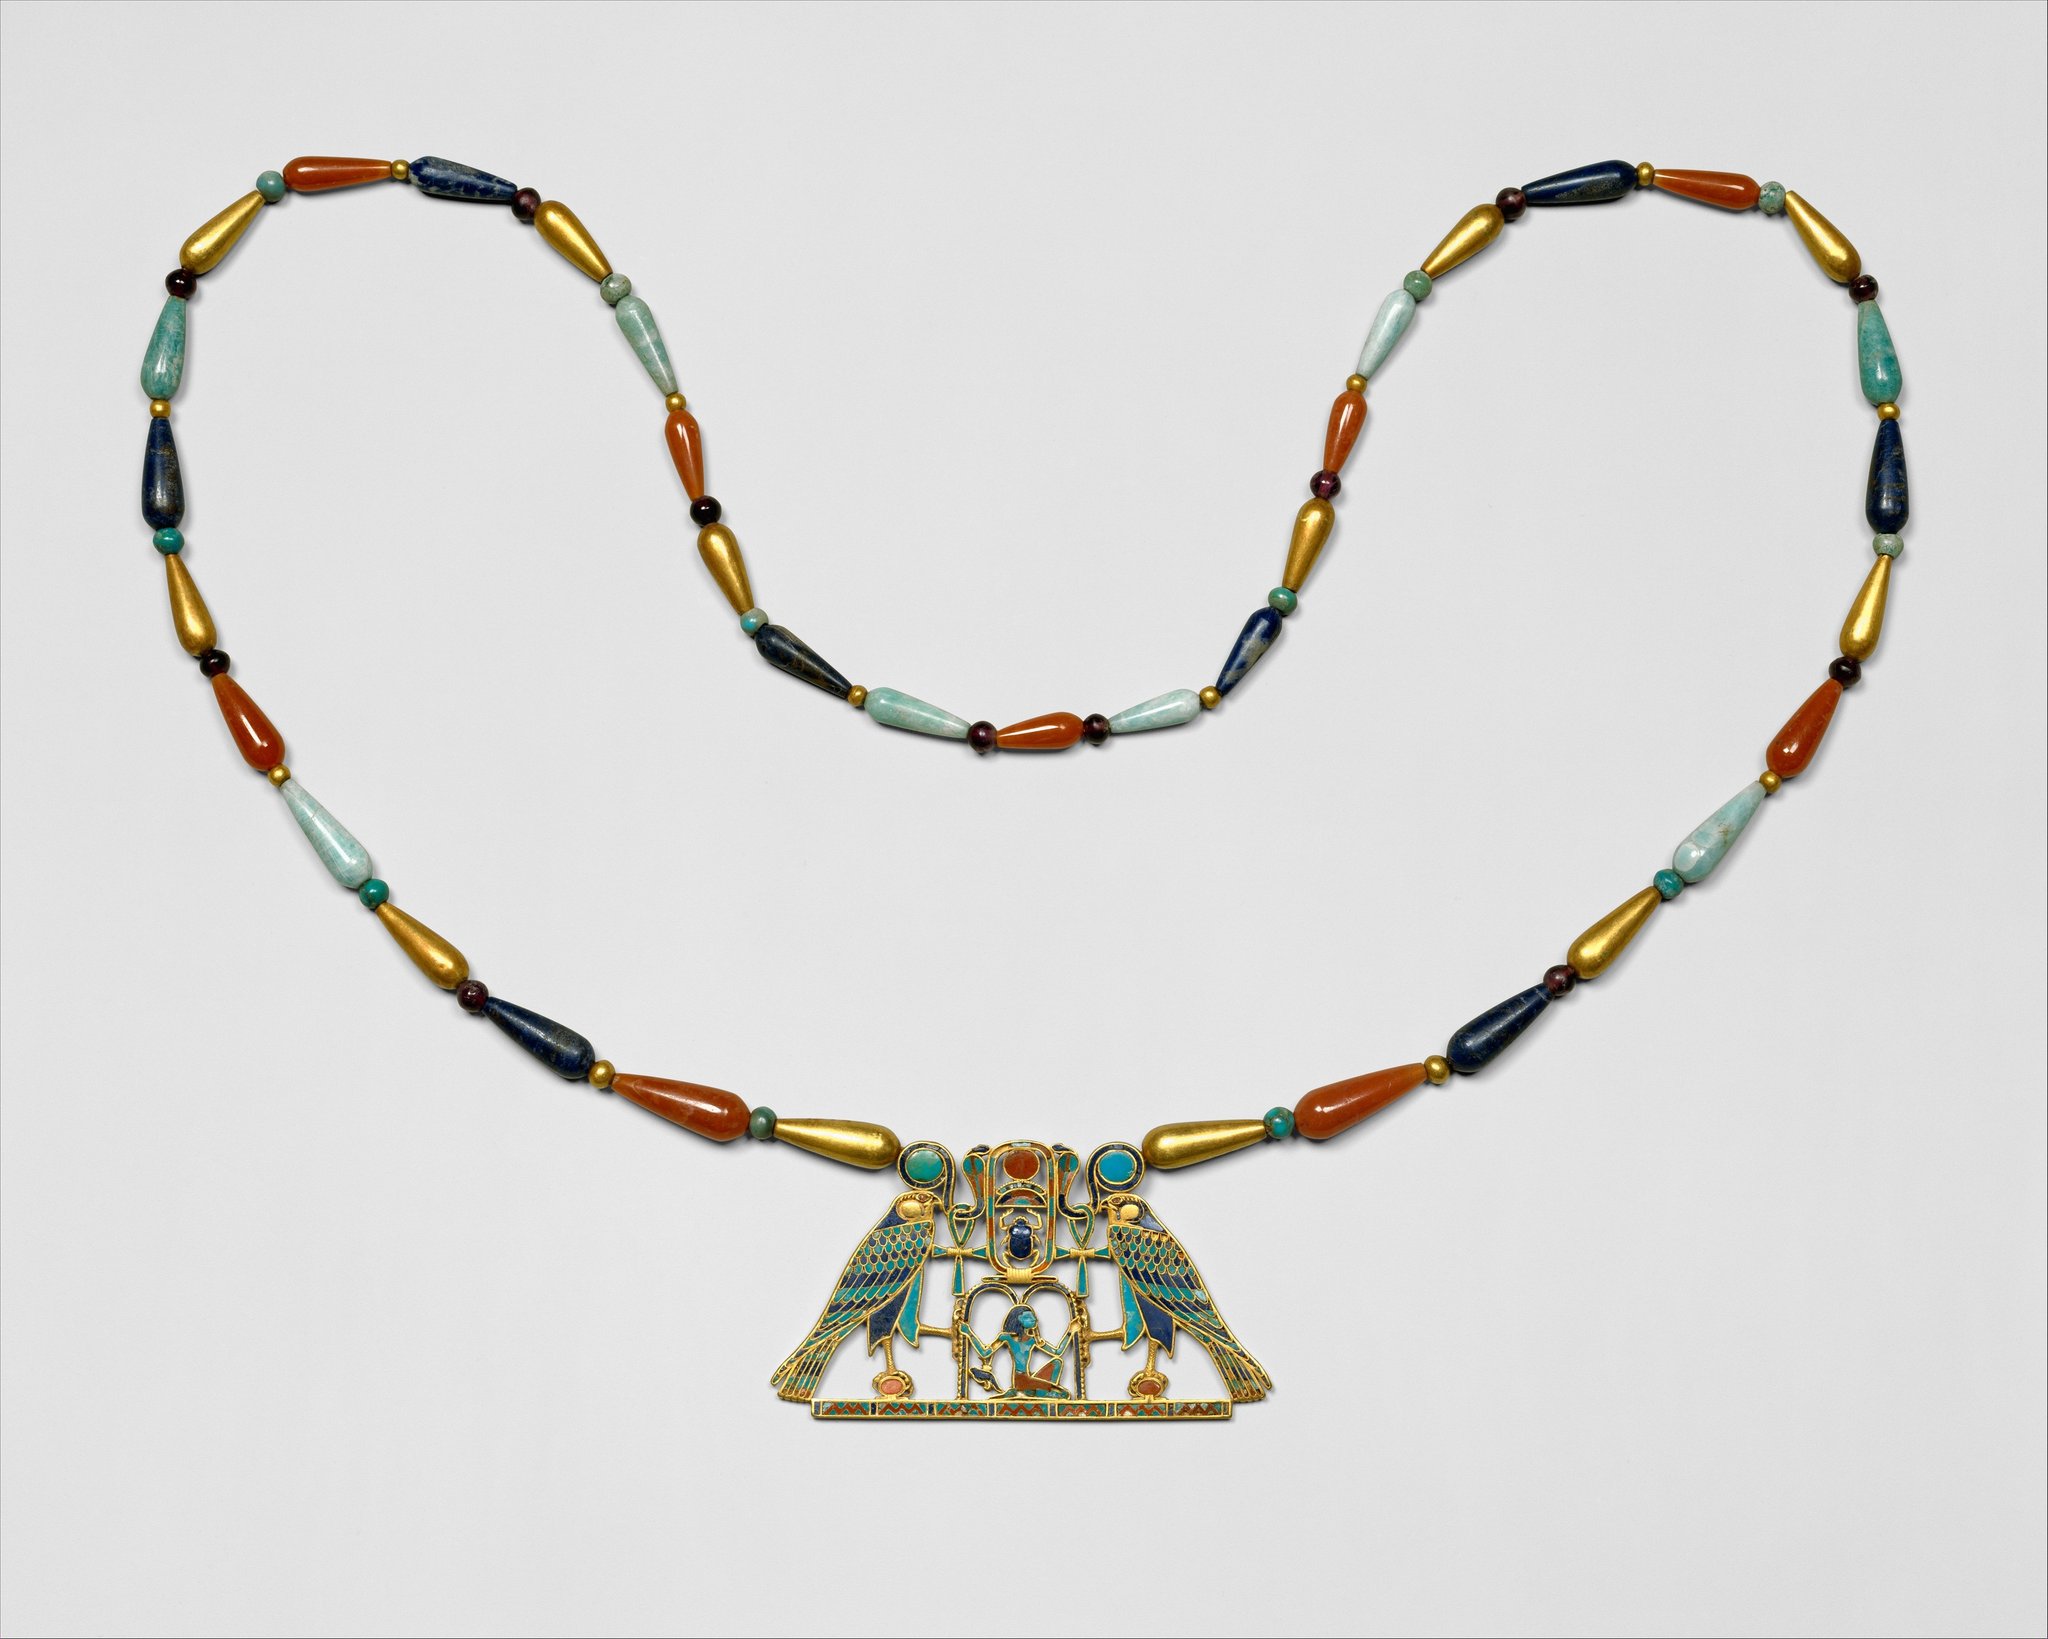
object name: necklace, pectoral, sithathoryunet view jewelry, senwosret ii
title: Pectoral and Necklace of Sithathoryunet with the Name of Senwosret II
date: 1887-1878 BCE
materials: gemstone, gold, lapis lazuli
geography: egypt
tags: falcons,hieroglyphs,sithathoryunet-jewelry